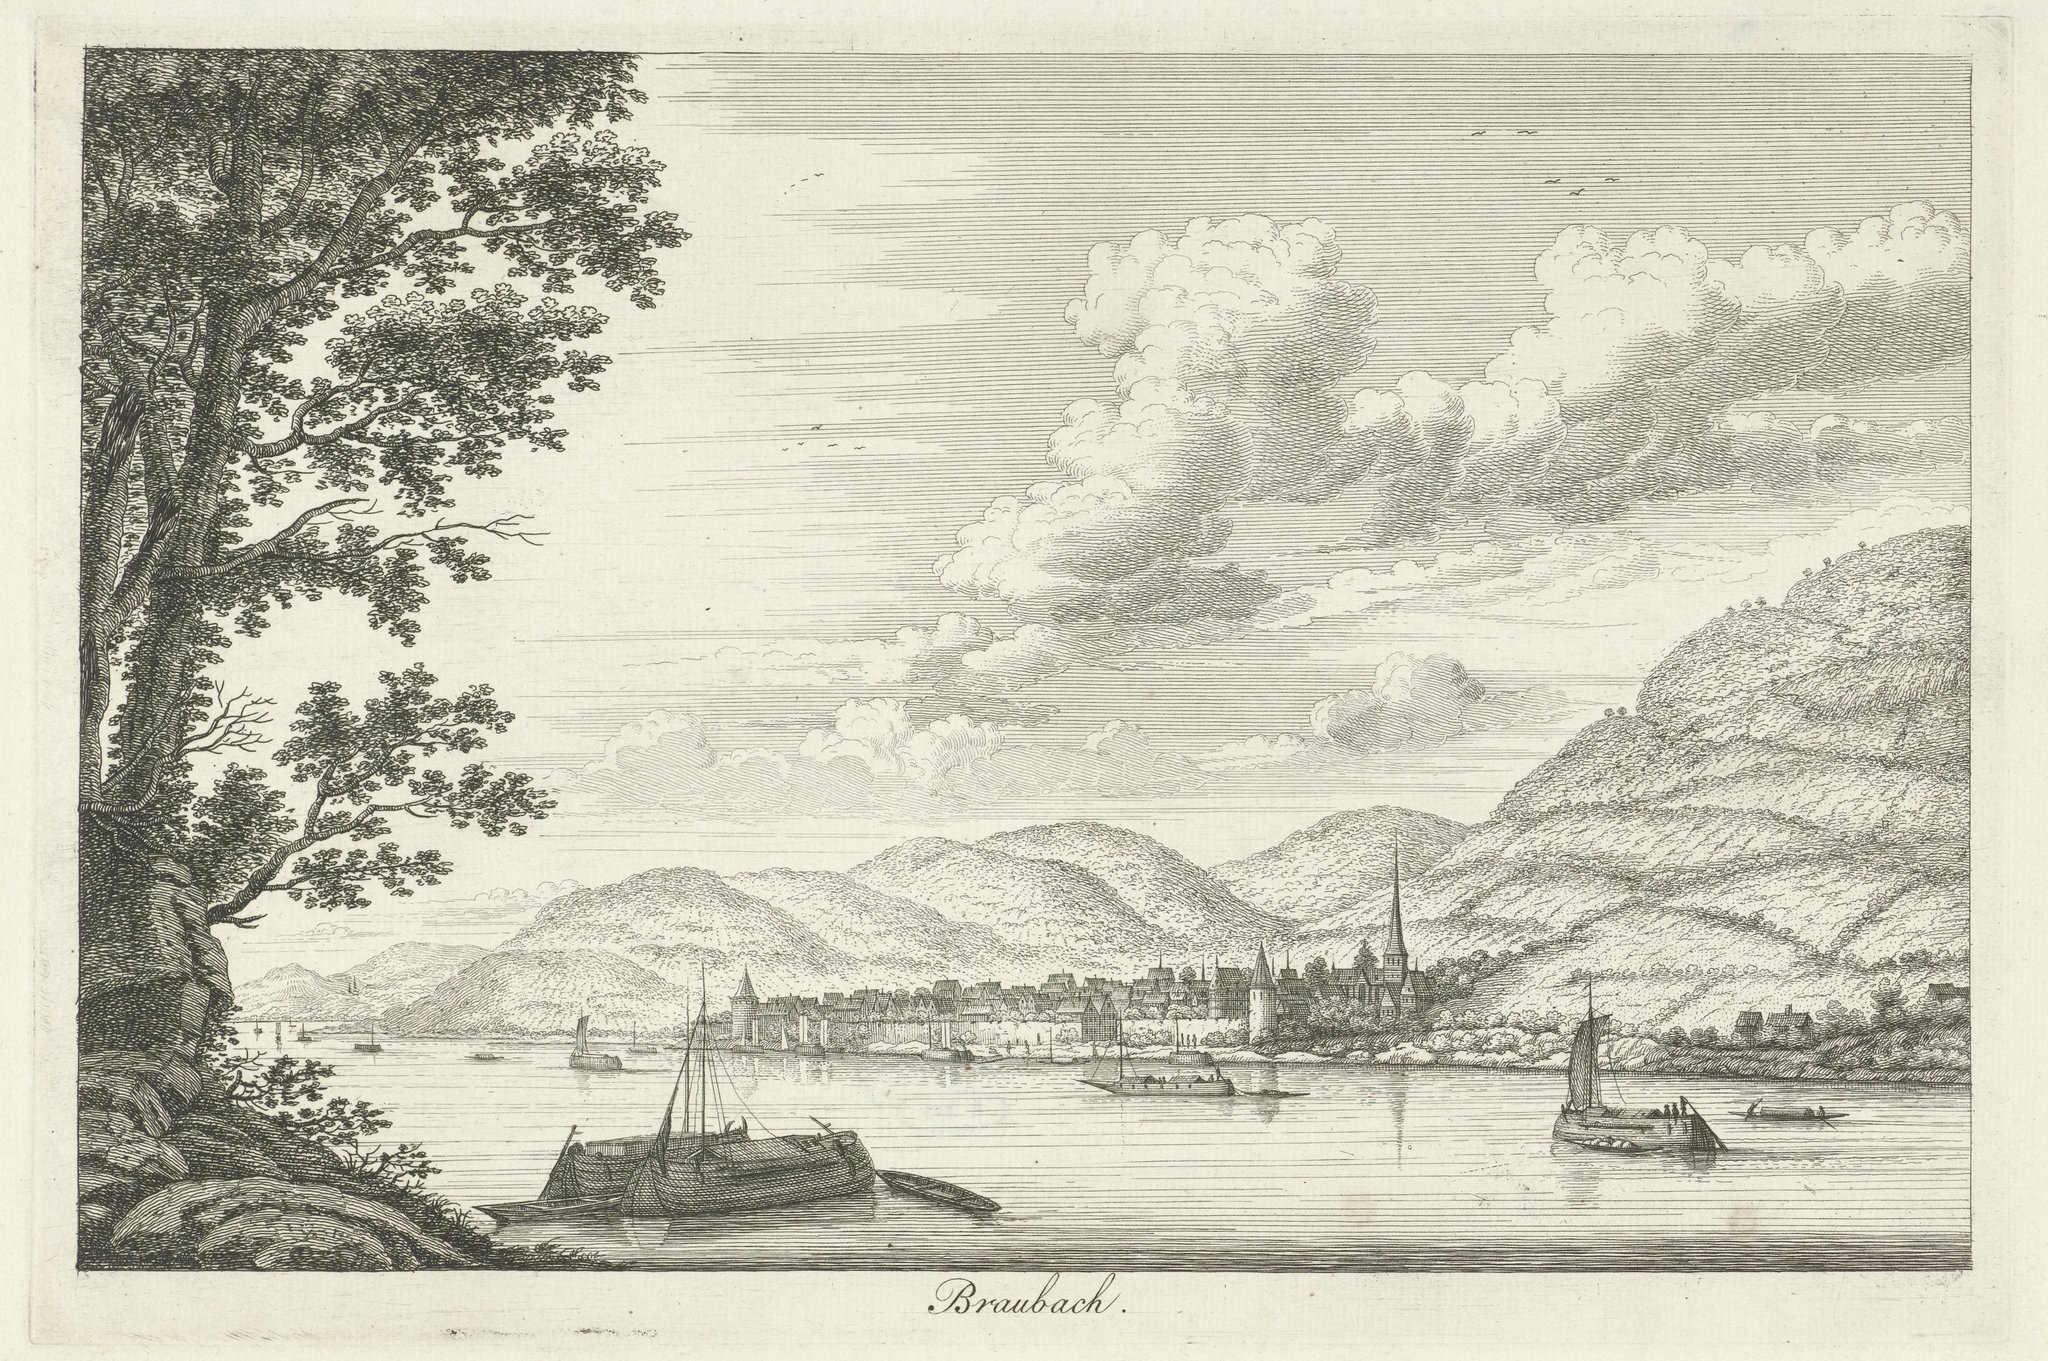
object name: print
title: Braubach, gezien vanaf de Rijn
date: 1767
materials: paper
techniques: etching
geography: amsterdam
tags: river, ships (in general), prospect of city, town panorama, silhouette of city, braubach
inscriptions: collector's mark: Lugt 2228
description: De Duitse stad Braubach, gezien vanaf de Rijn. De prent maakt deel uit van een elfdelige serie prenten met gezichten langs de Rijn.